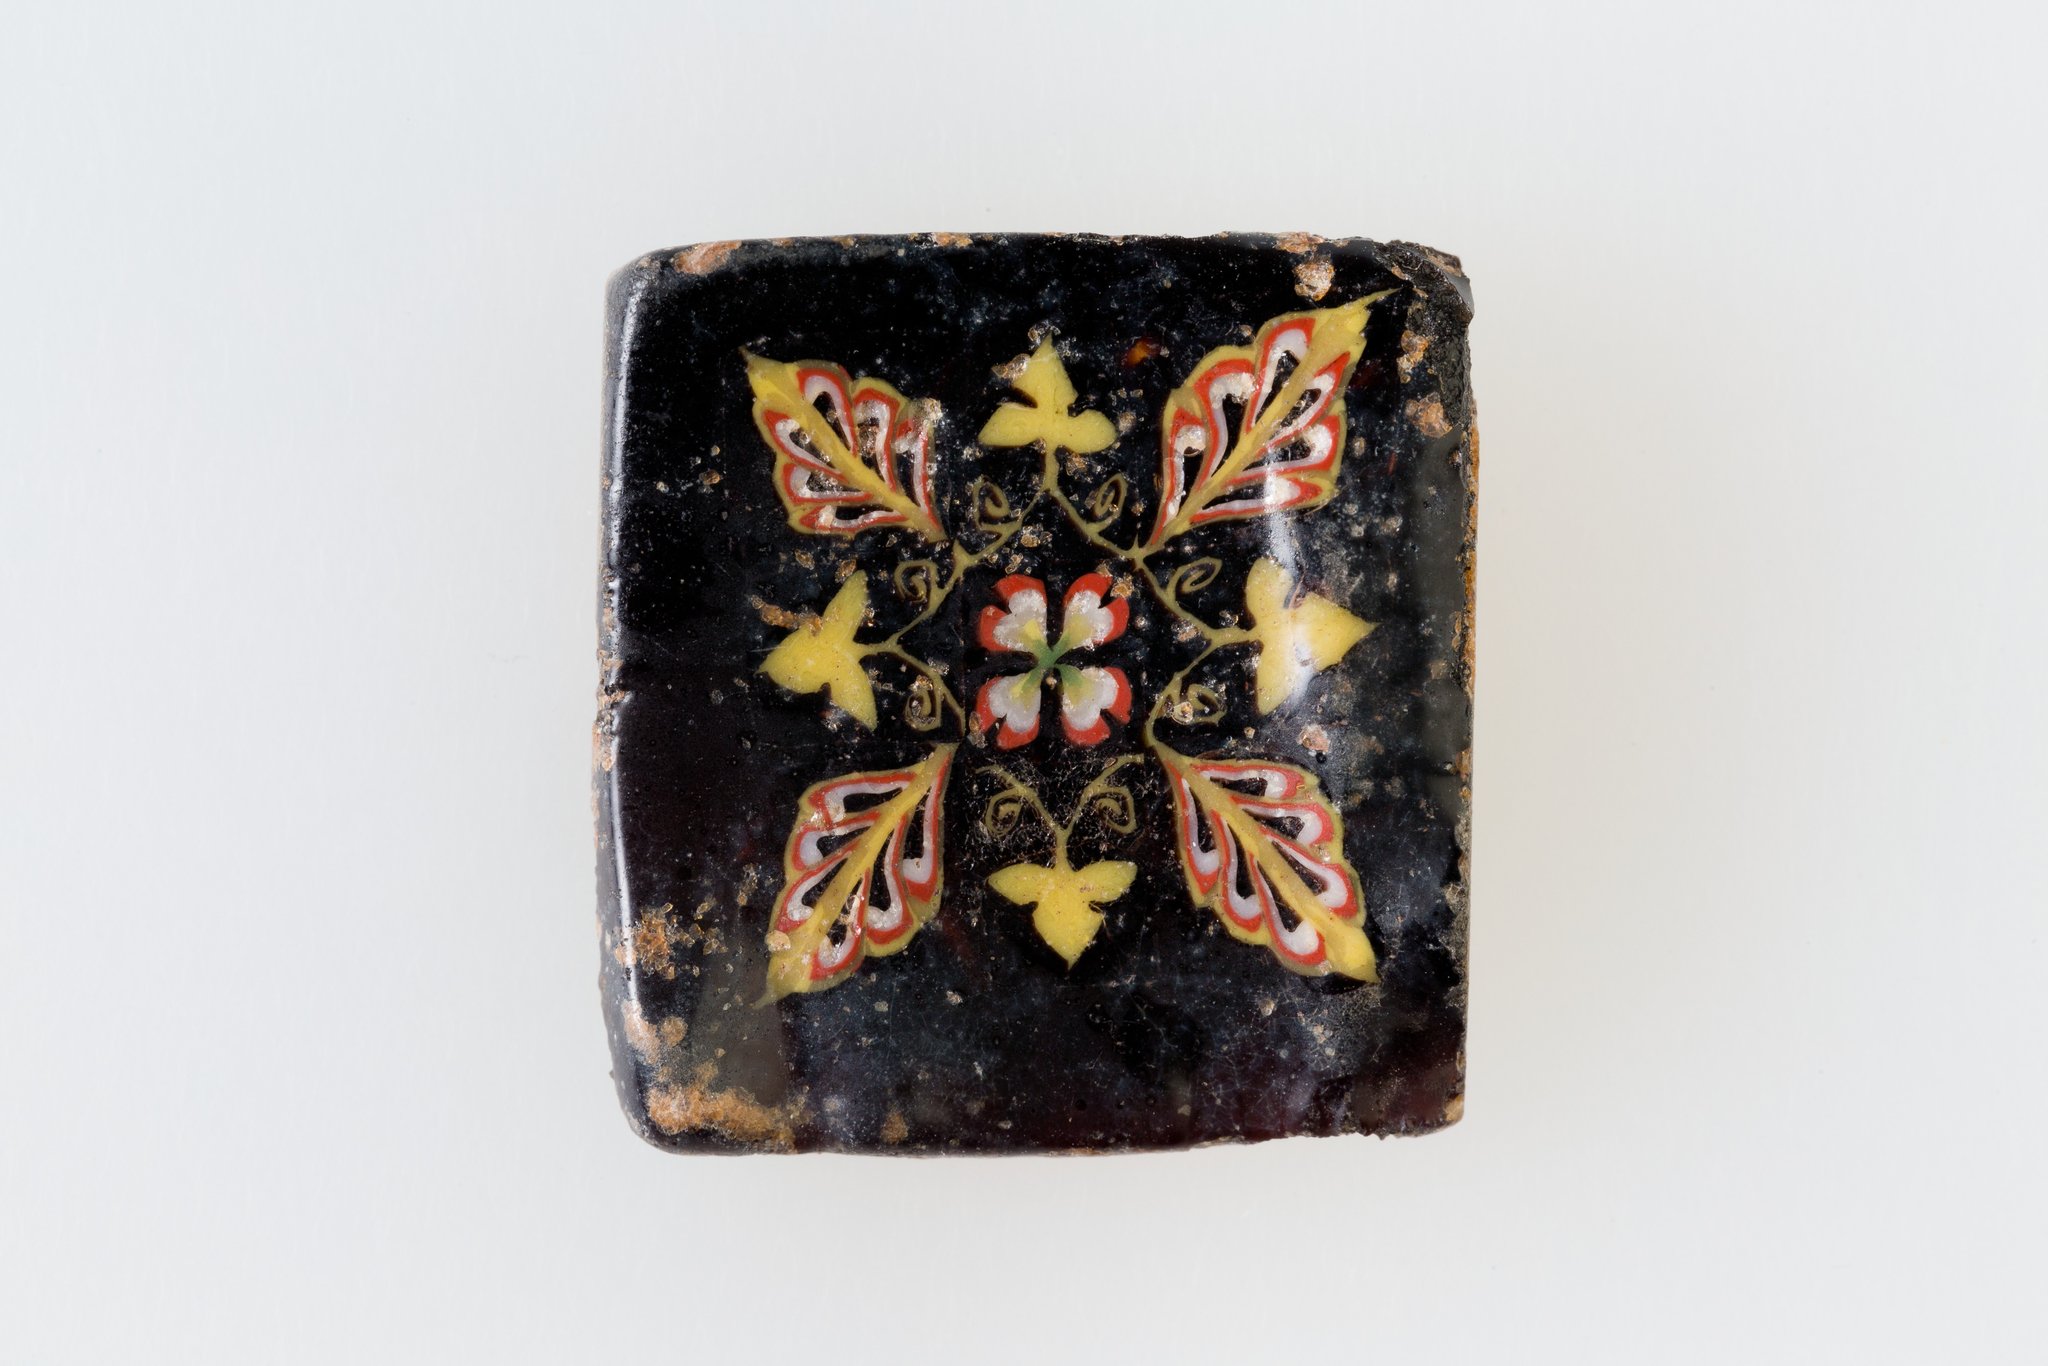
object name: inlay, palmette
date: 100 BCE-100 CE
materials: glass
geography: egypt